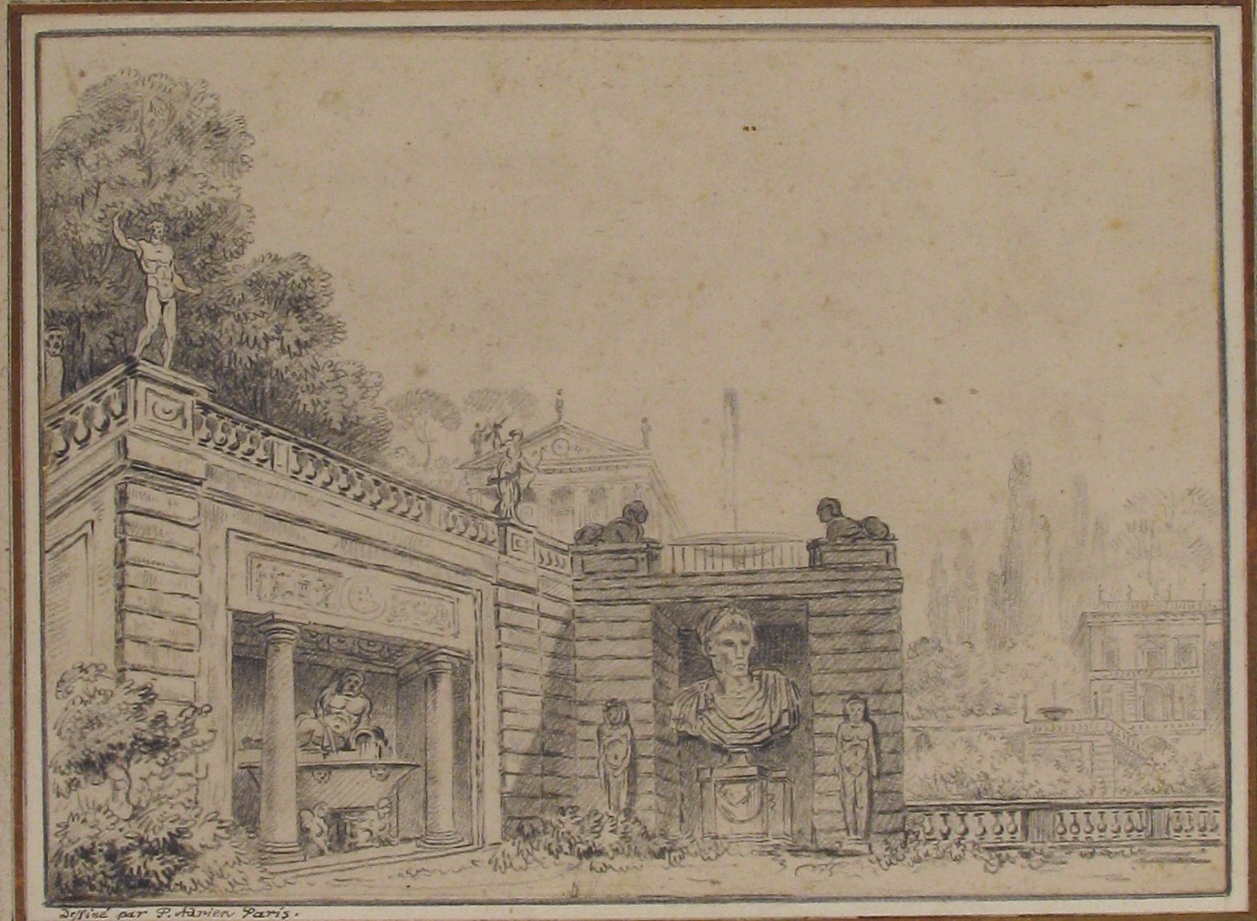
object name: drawing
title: The Base of the Terrace at the Villa Albani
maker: pierre adrien pâris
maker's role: draughtsman, print maker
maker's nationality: french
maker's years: 1745-1819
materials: chalk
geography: france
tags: human figures,houses,trees,rome